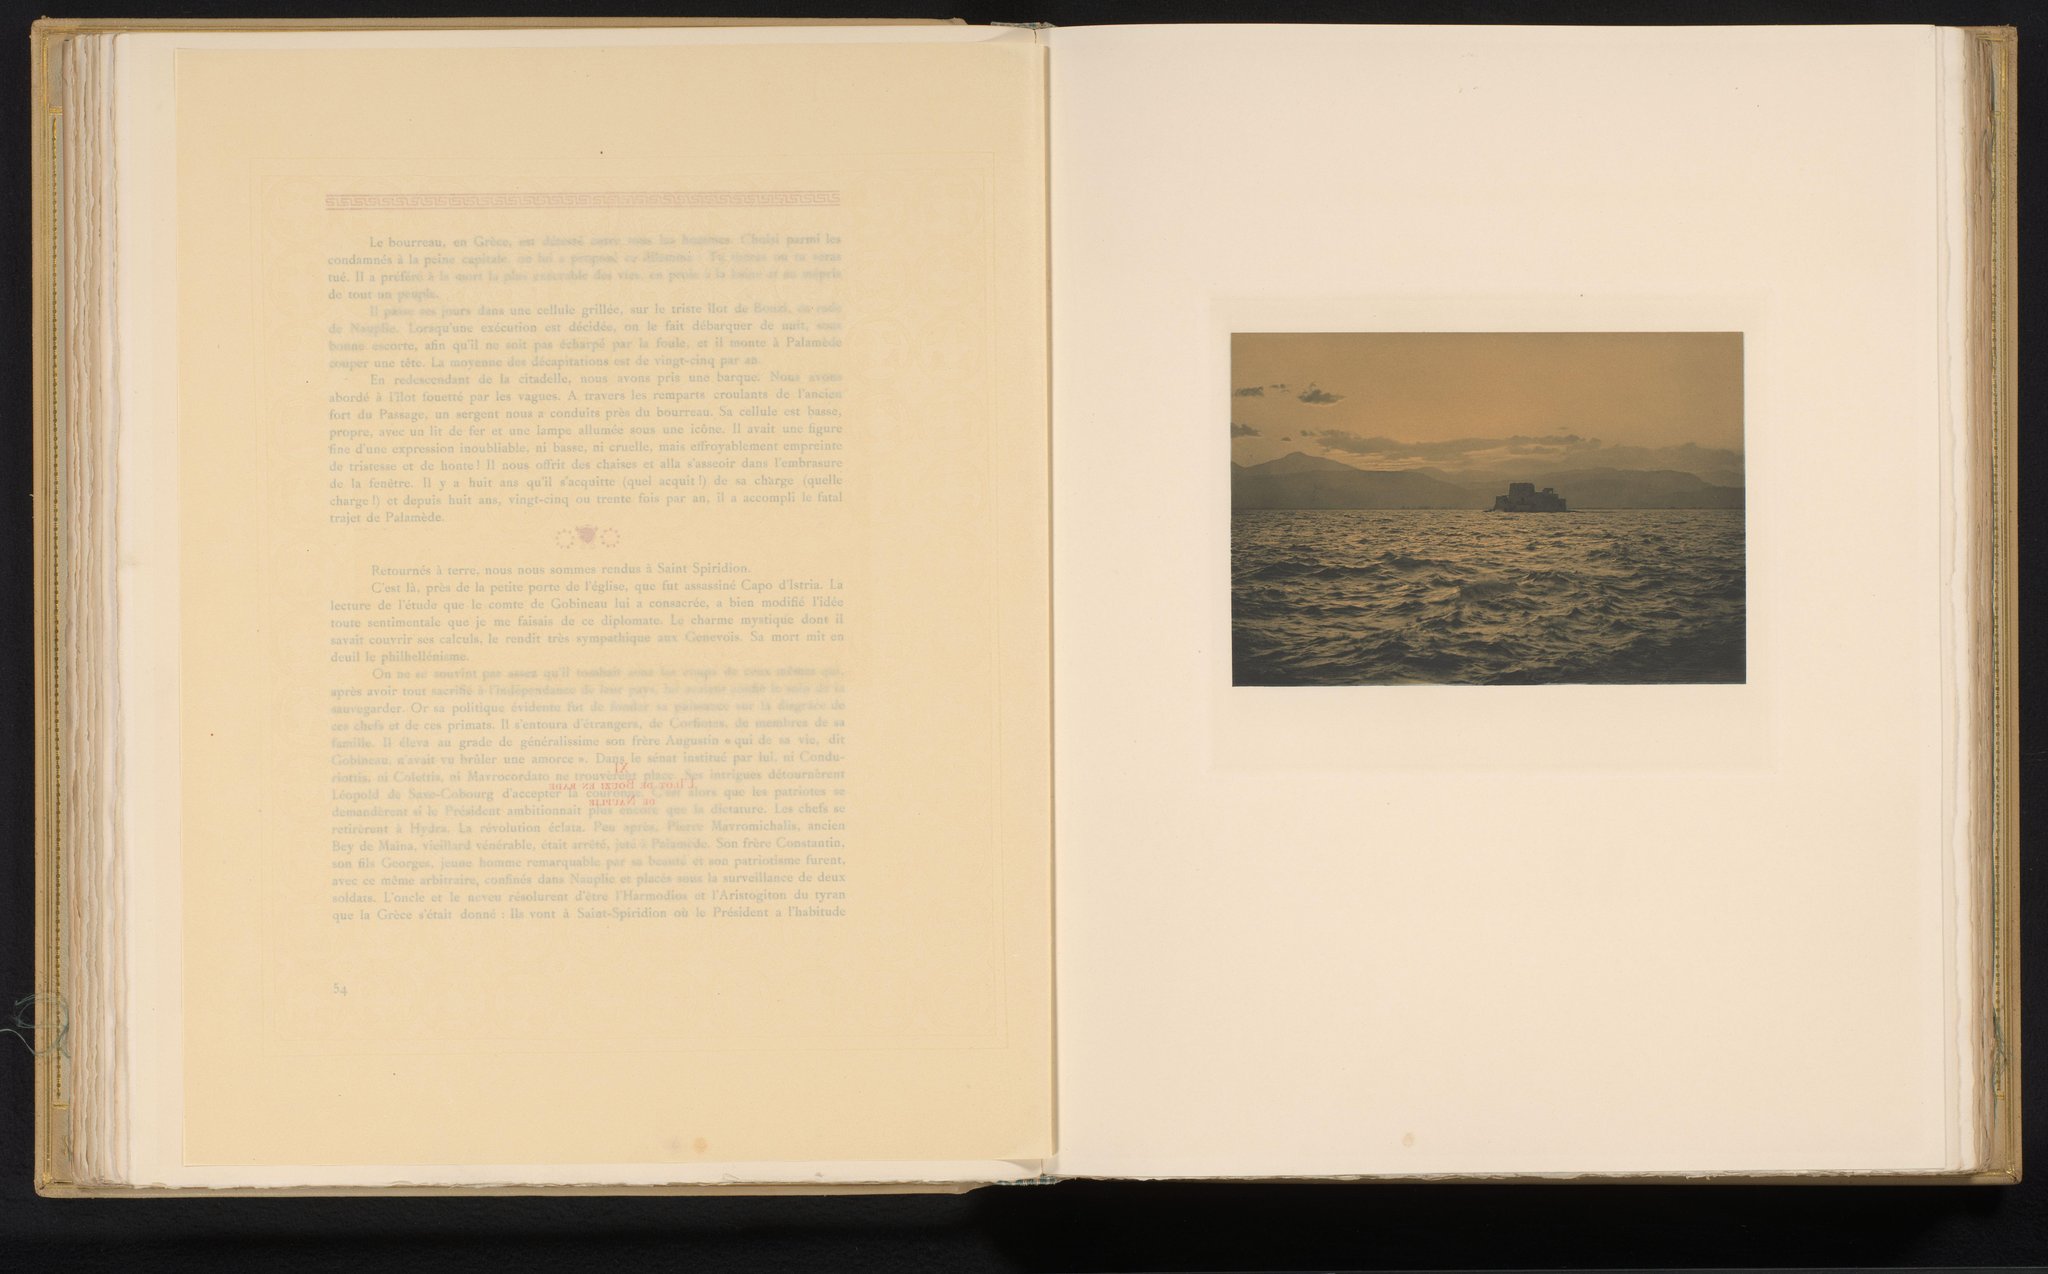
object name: page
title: L'Ilot de Bouzi en rade de Nauplie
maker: frédéric boissonnas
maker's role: fotograaf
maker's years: 1858-1946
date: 1905-1910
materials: paper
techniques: photoaquatint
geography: nauplion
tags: fortress, island